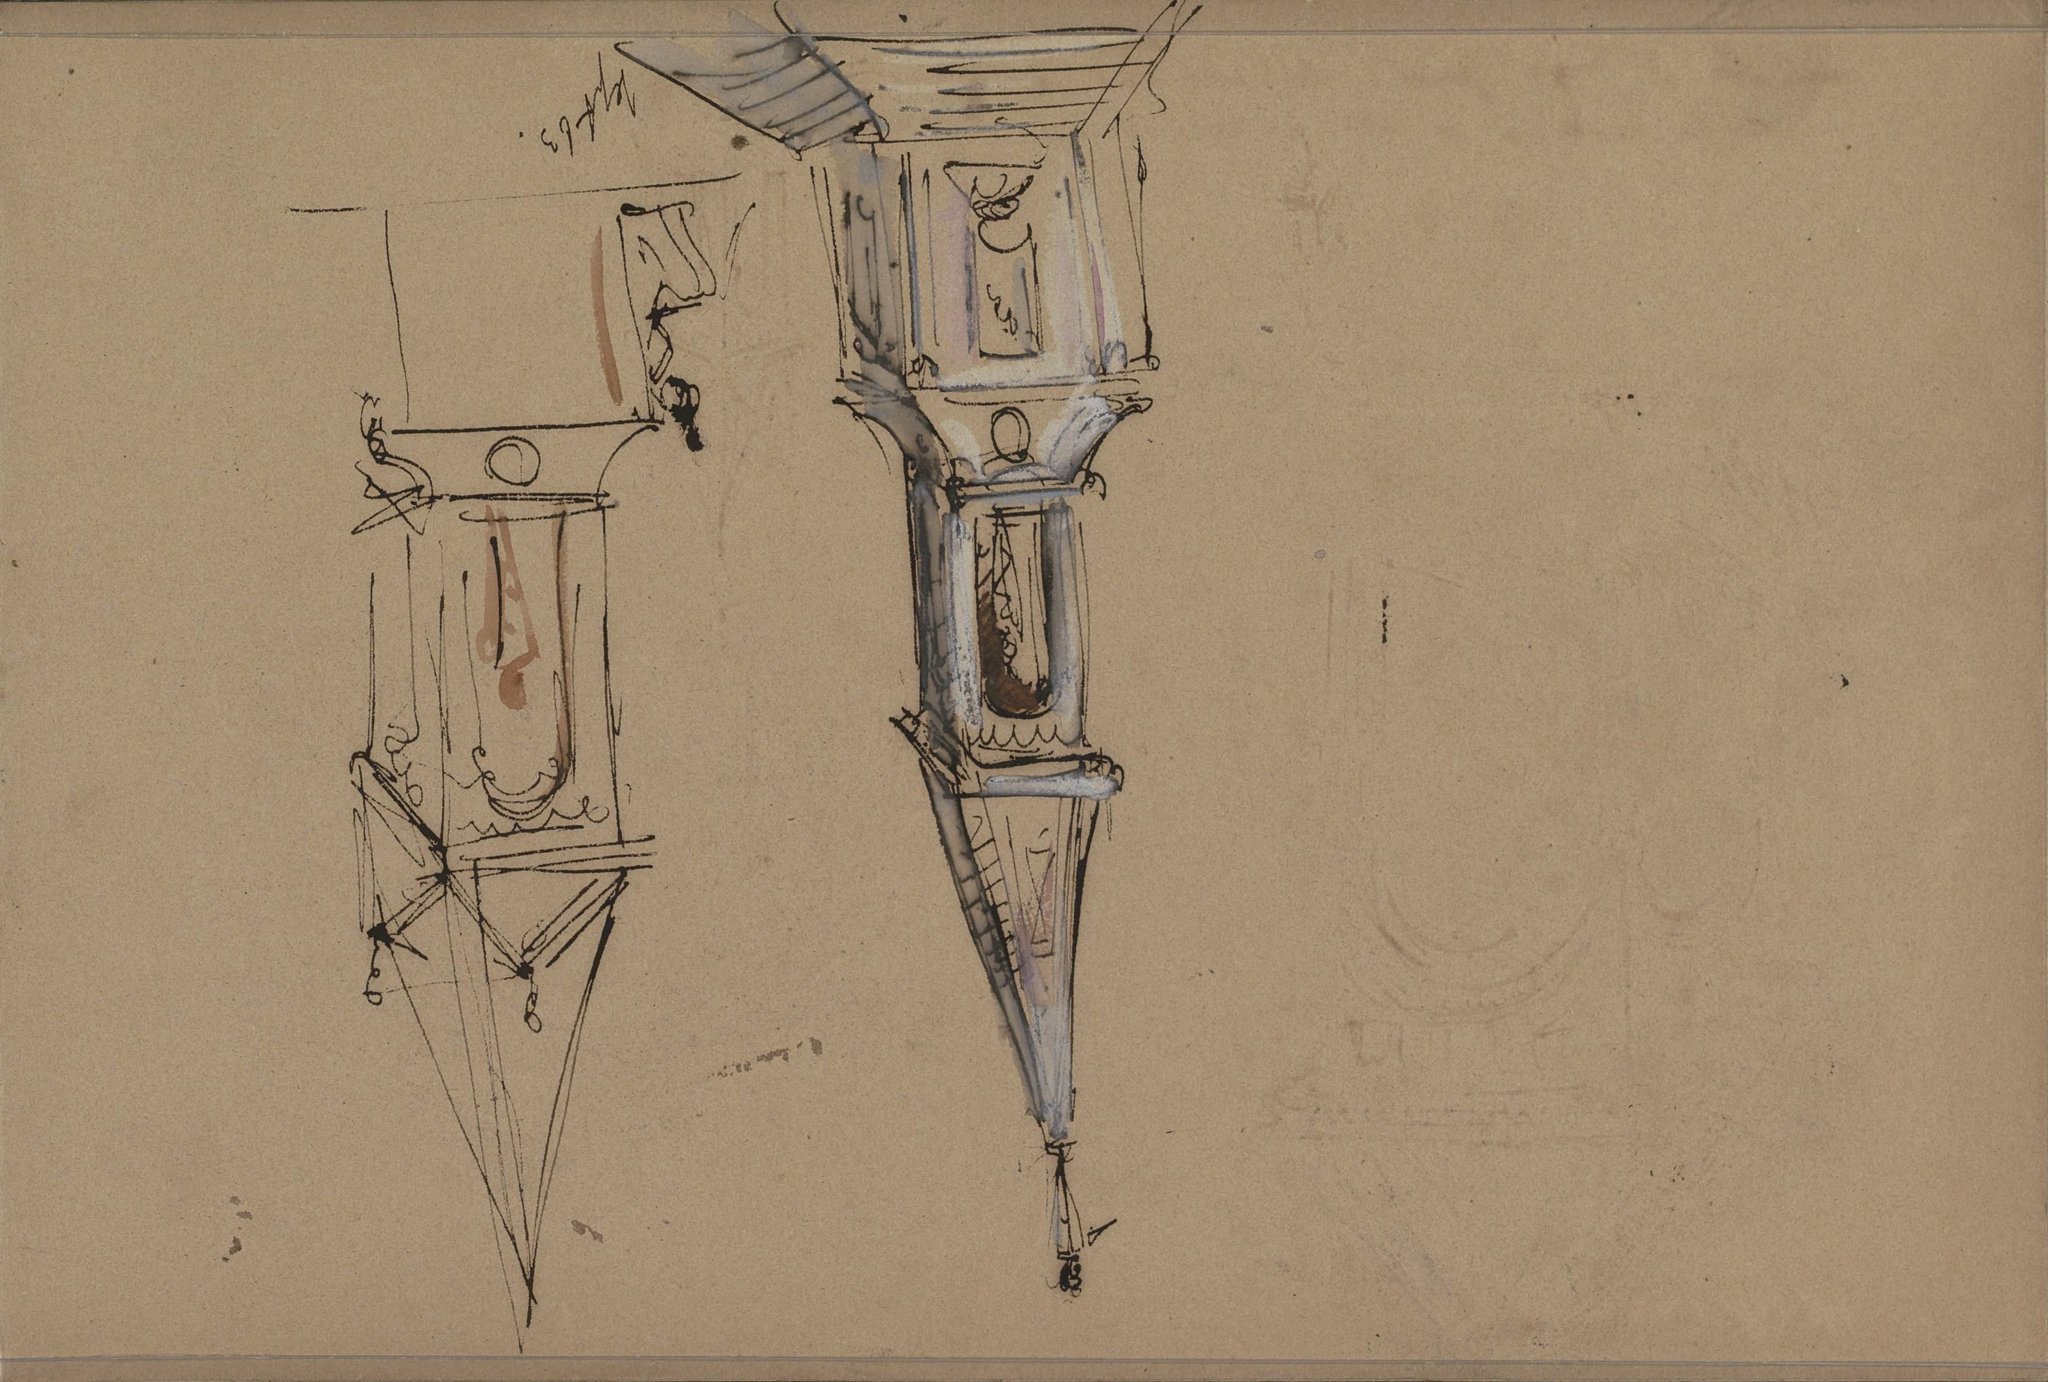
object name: sketchbook leaf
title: Torenspitsen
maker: isaac gosschalk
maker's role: draughtsman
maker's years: 1838-1907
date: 1862-1867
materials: ink, paper, watercolor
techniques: brush, pen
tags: tower (of house or building)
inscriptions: date: ‘sept 63.’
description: Recto-zijde van blad 58, achterste vrije schutblad uit een schetsboek met 58 bladen.